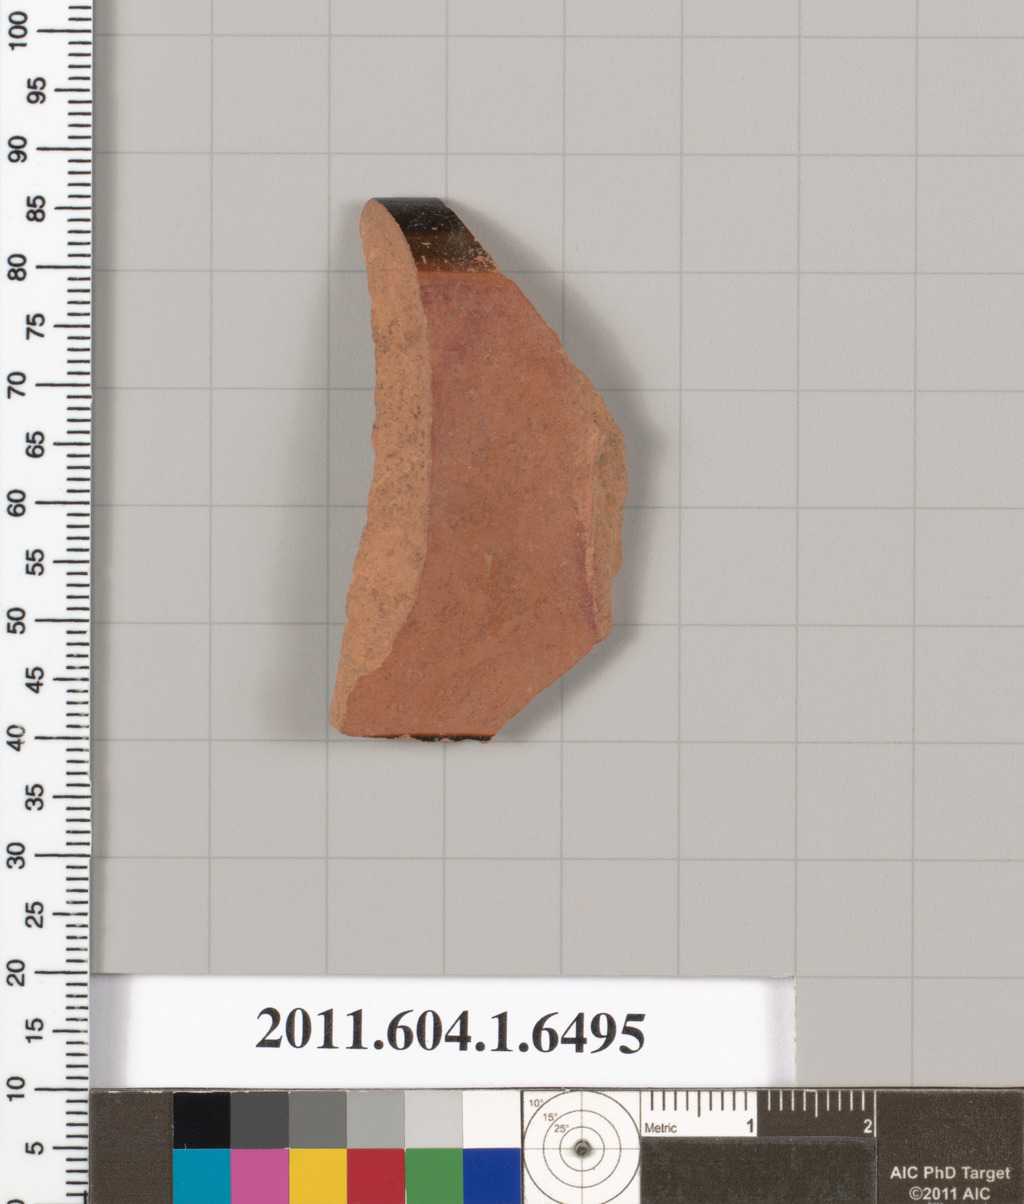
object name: kylix fragment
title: Terracotta fragment of a kylix (drinking cup)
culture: greek, attic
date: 490-480 BCE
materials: terracotta